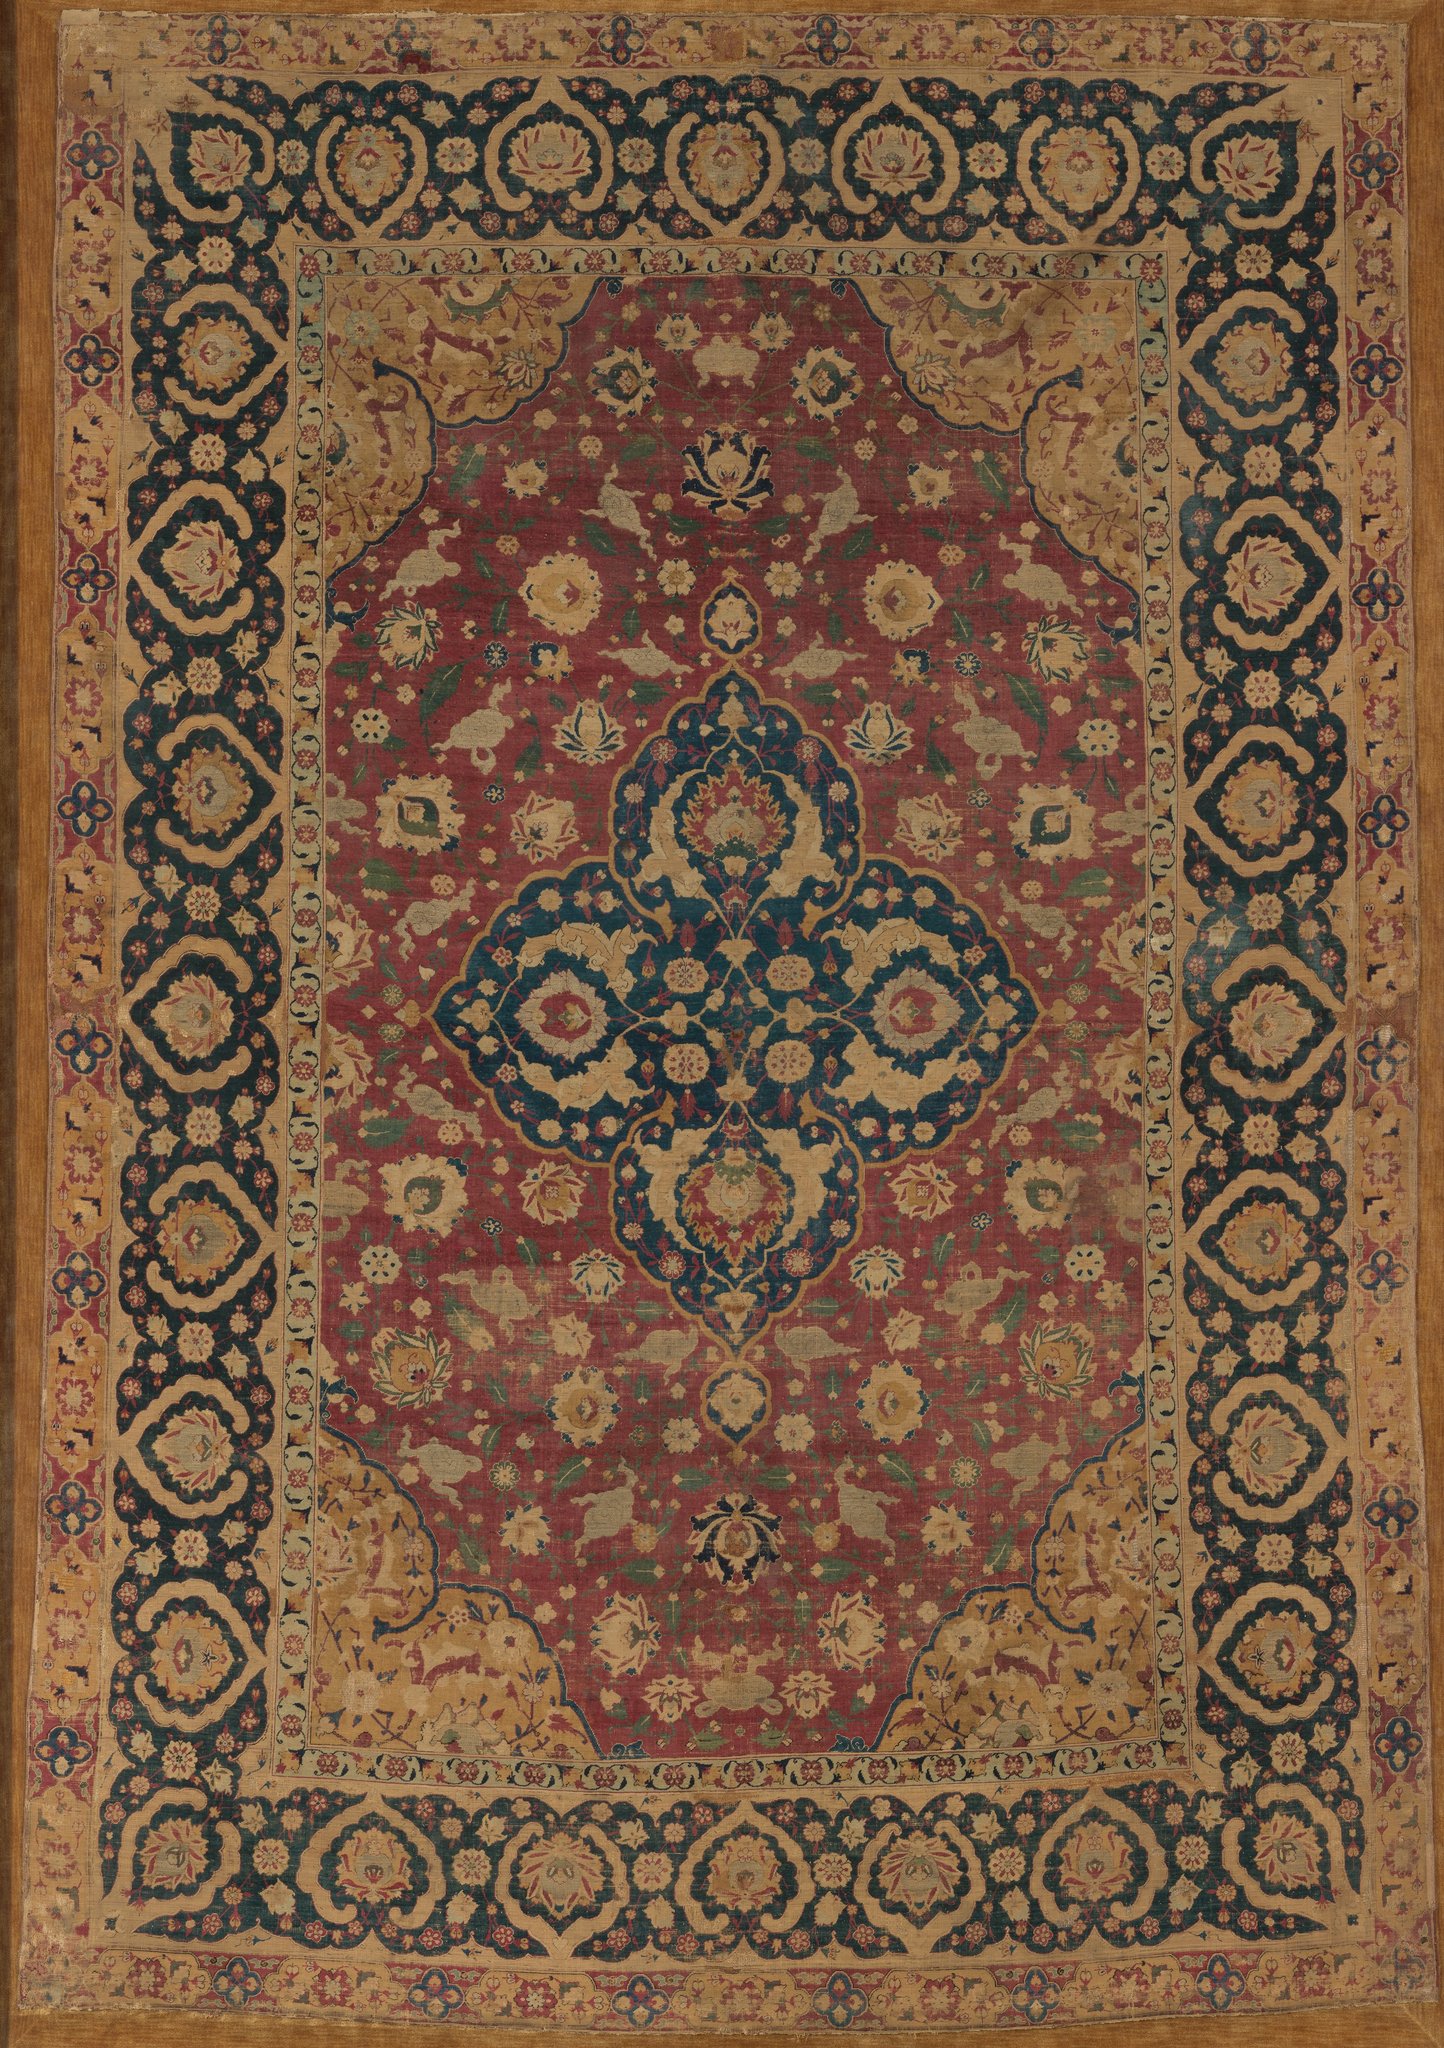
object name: carpet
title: Silk Kashan Carpet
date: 1551-1600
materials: metal thread, silk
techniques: asymmetrically knotted pile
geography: iran